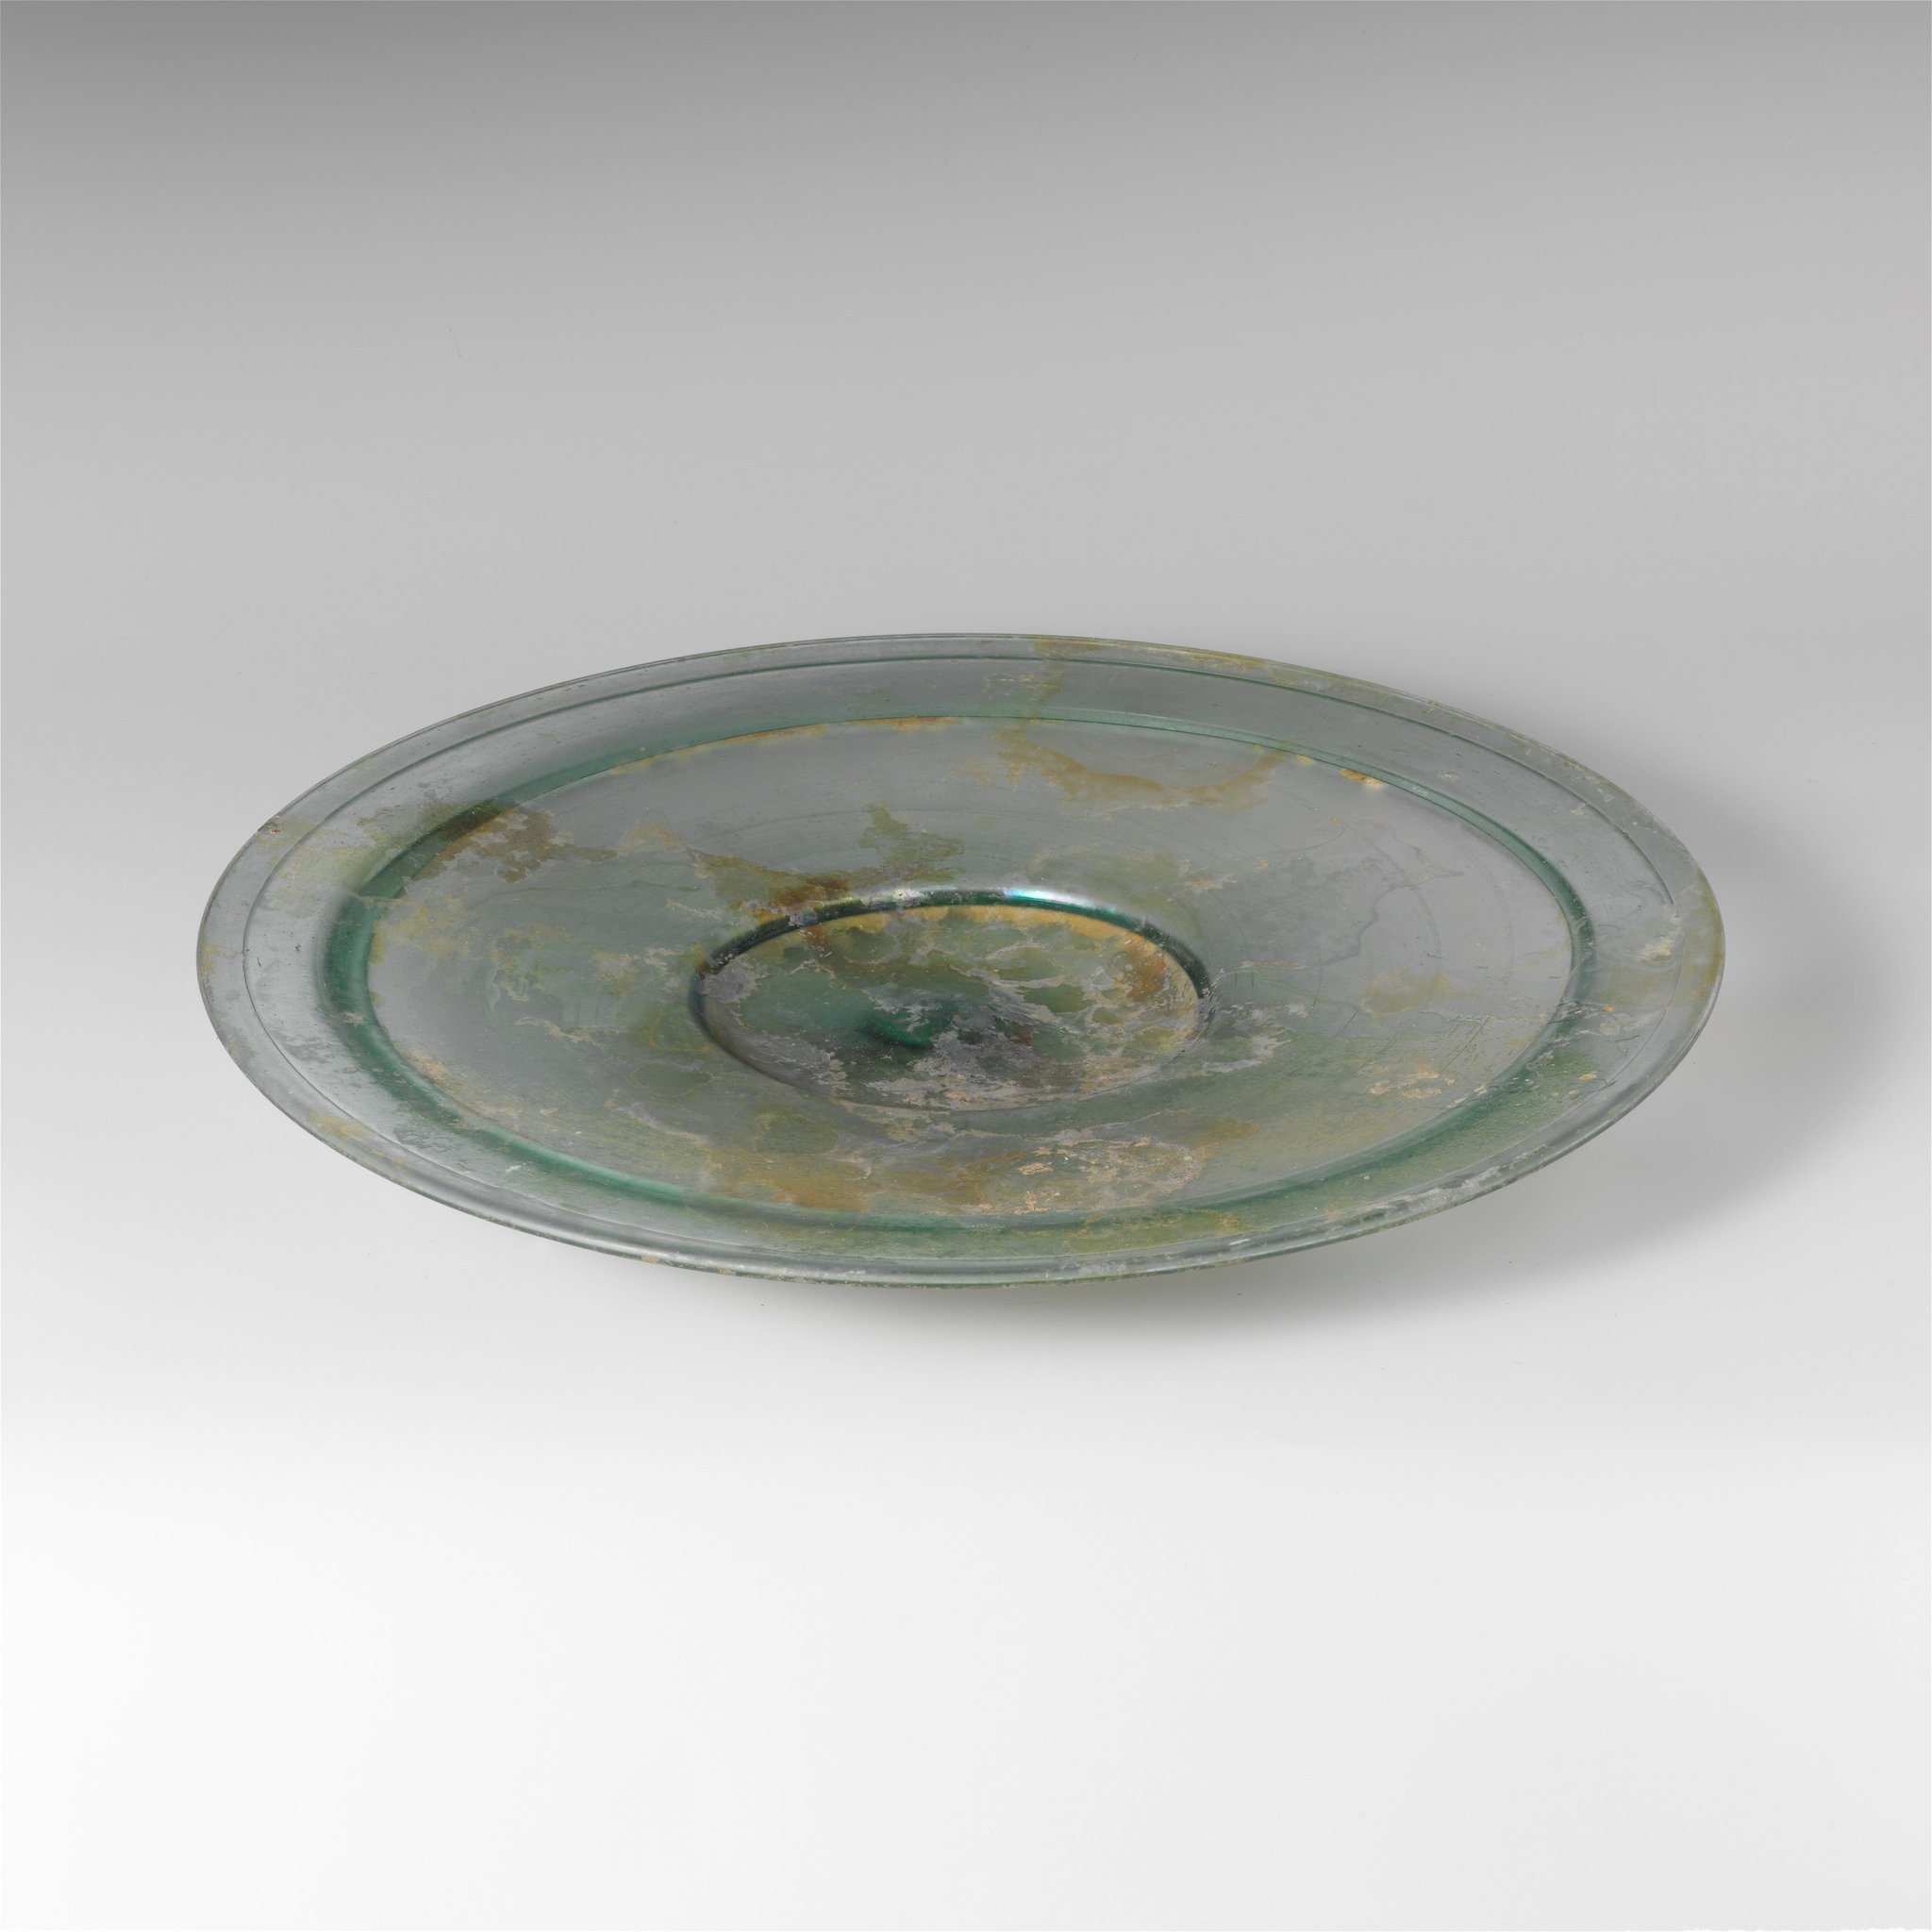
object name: plate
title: Glass plate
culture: roman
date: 301-400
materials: glass